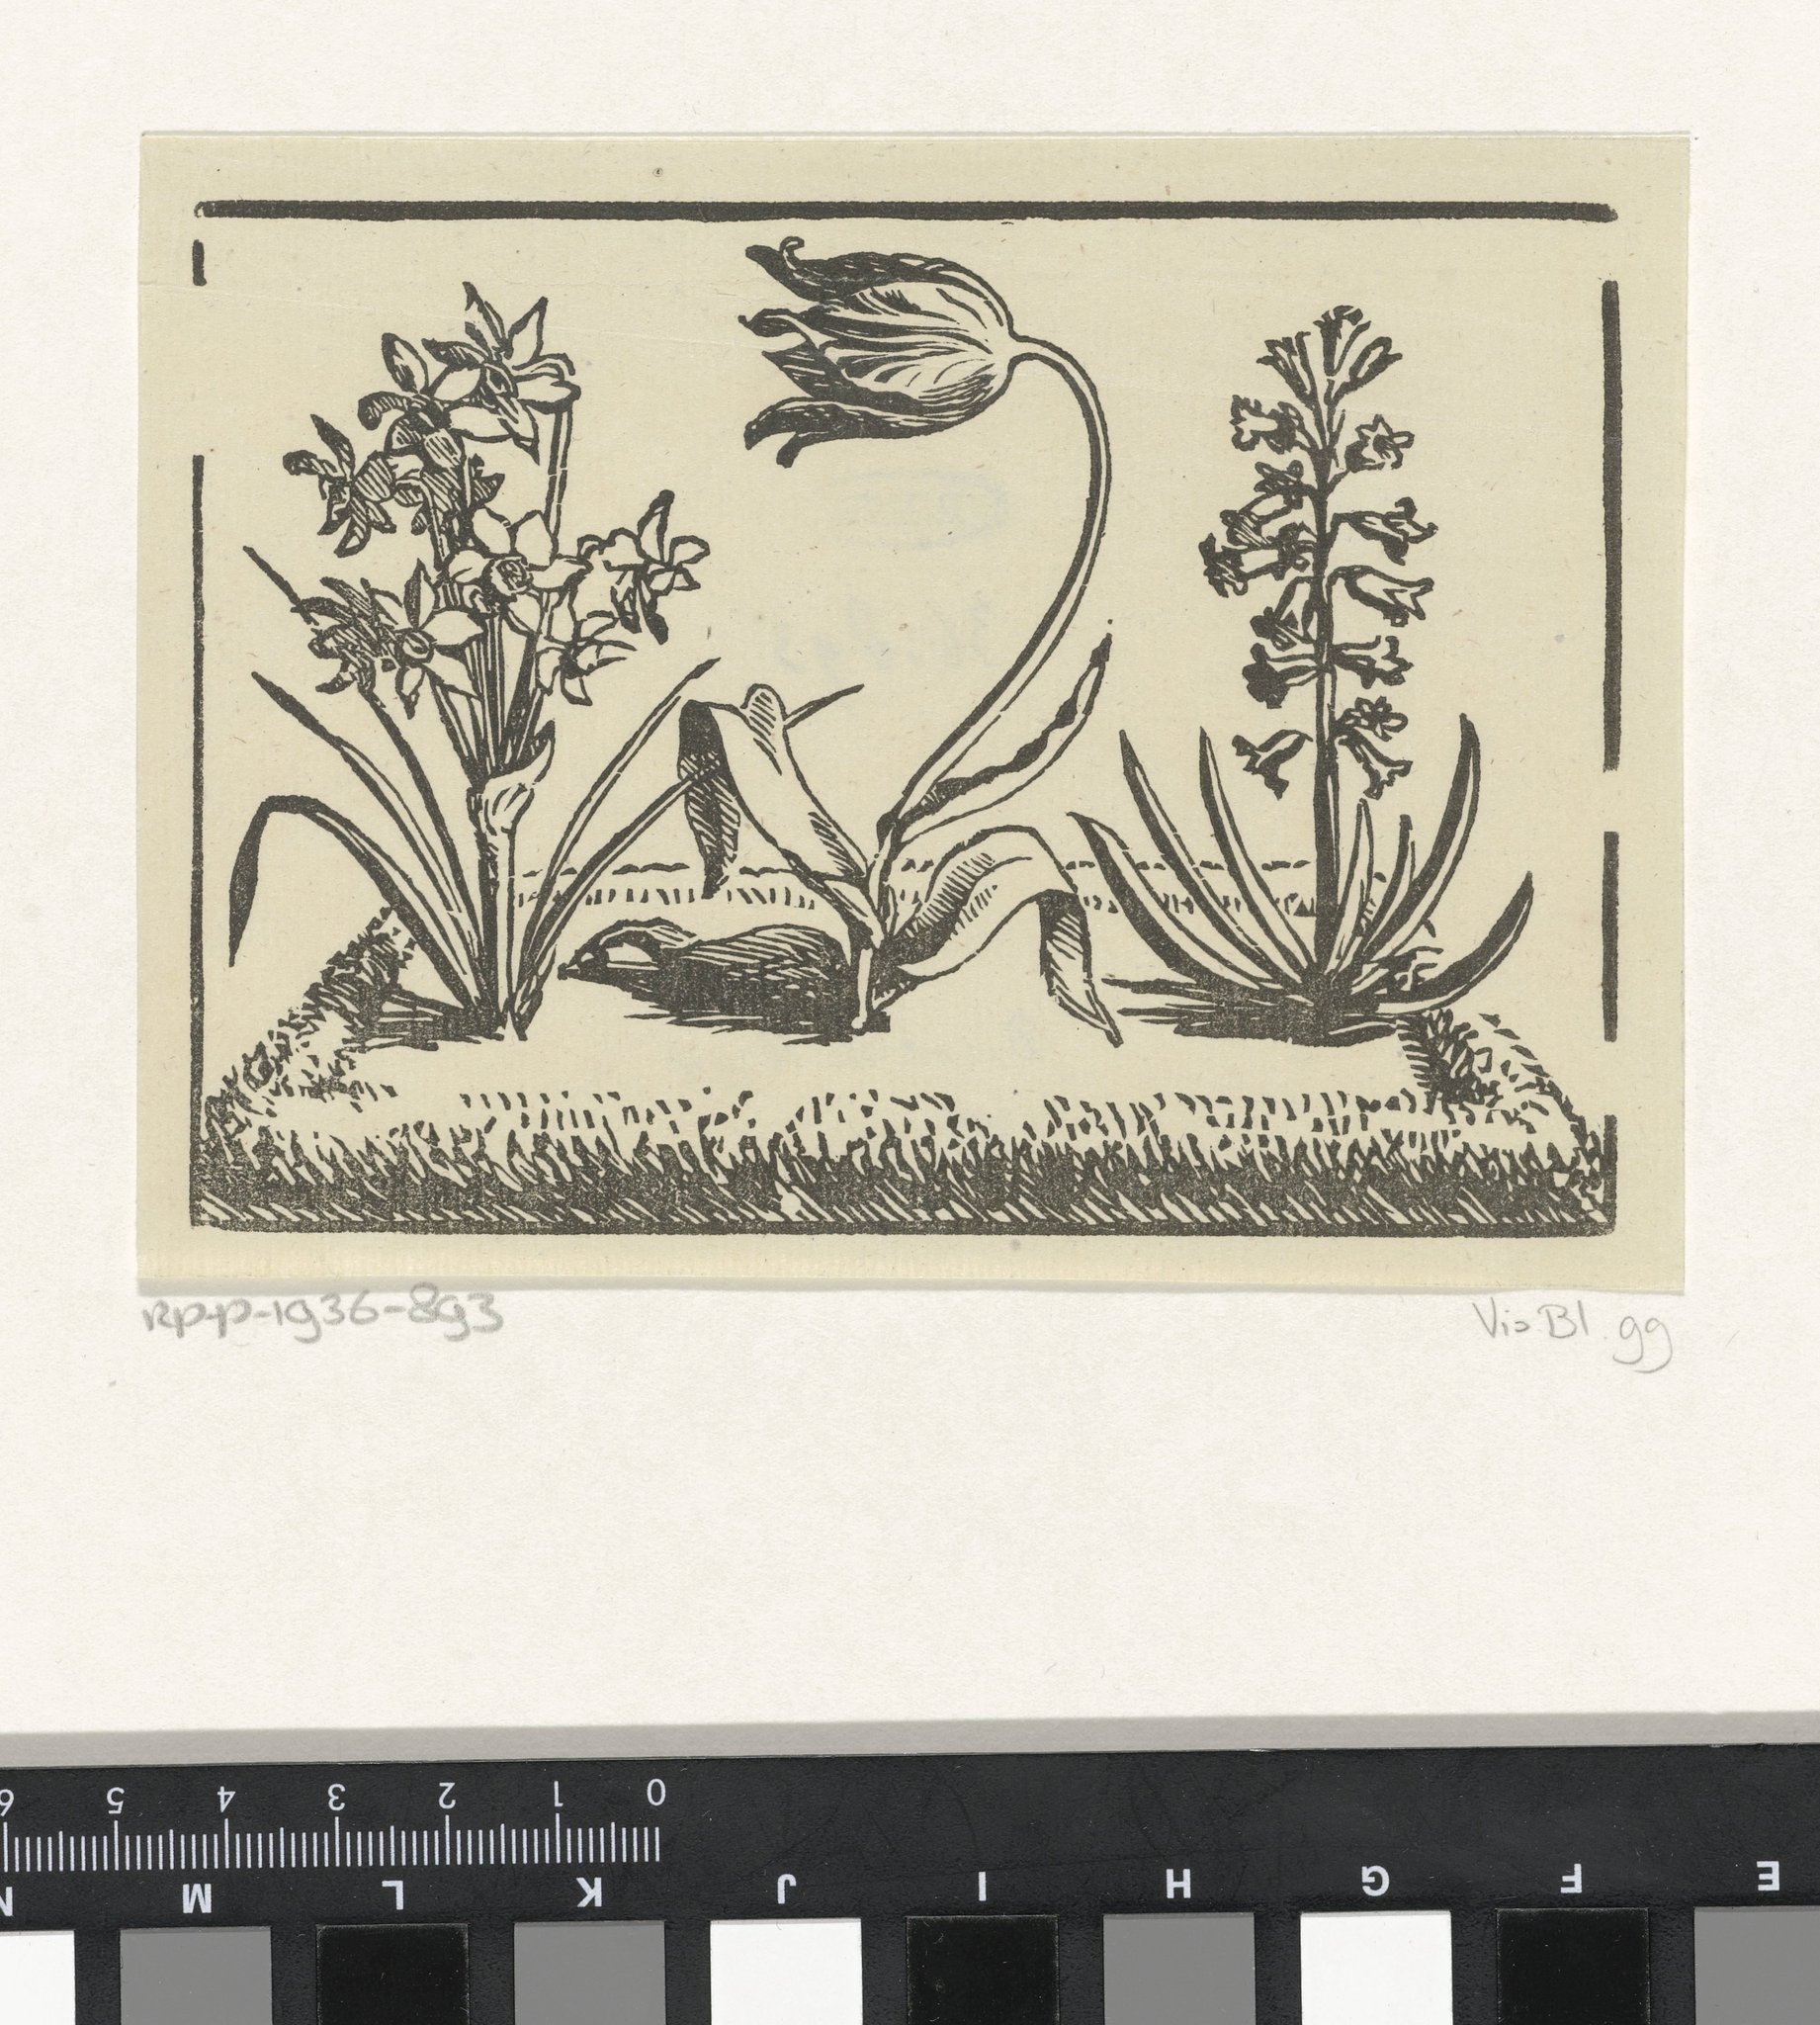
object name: print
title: Kleine tuin met een tulp, een narcis en een hyacint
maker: dirck de bray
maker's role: draughtsman, painter, print maker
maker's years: 1625-1694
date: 1635-1694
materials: paper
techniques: woodcut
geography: netherlands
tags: flowers: tulip, flowers: narcissus, flowers: hyacinth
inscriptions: collector's mark: Lugt 2228, collector's mark: Lugt 2760